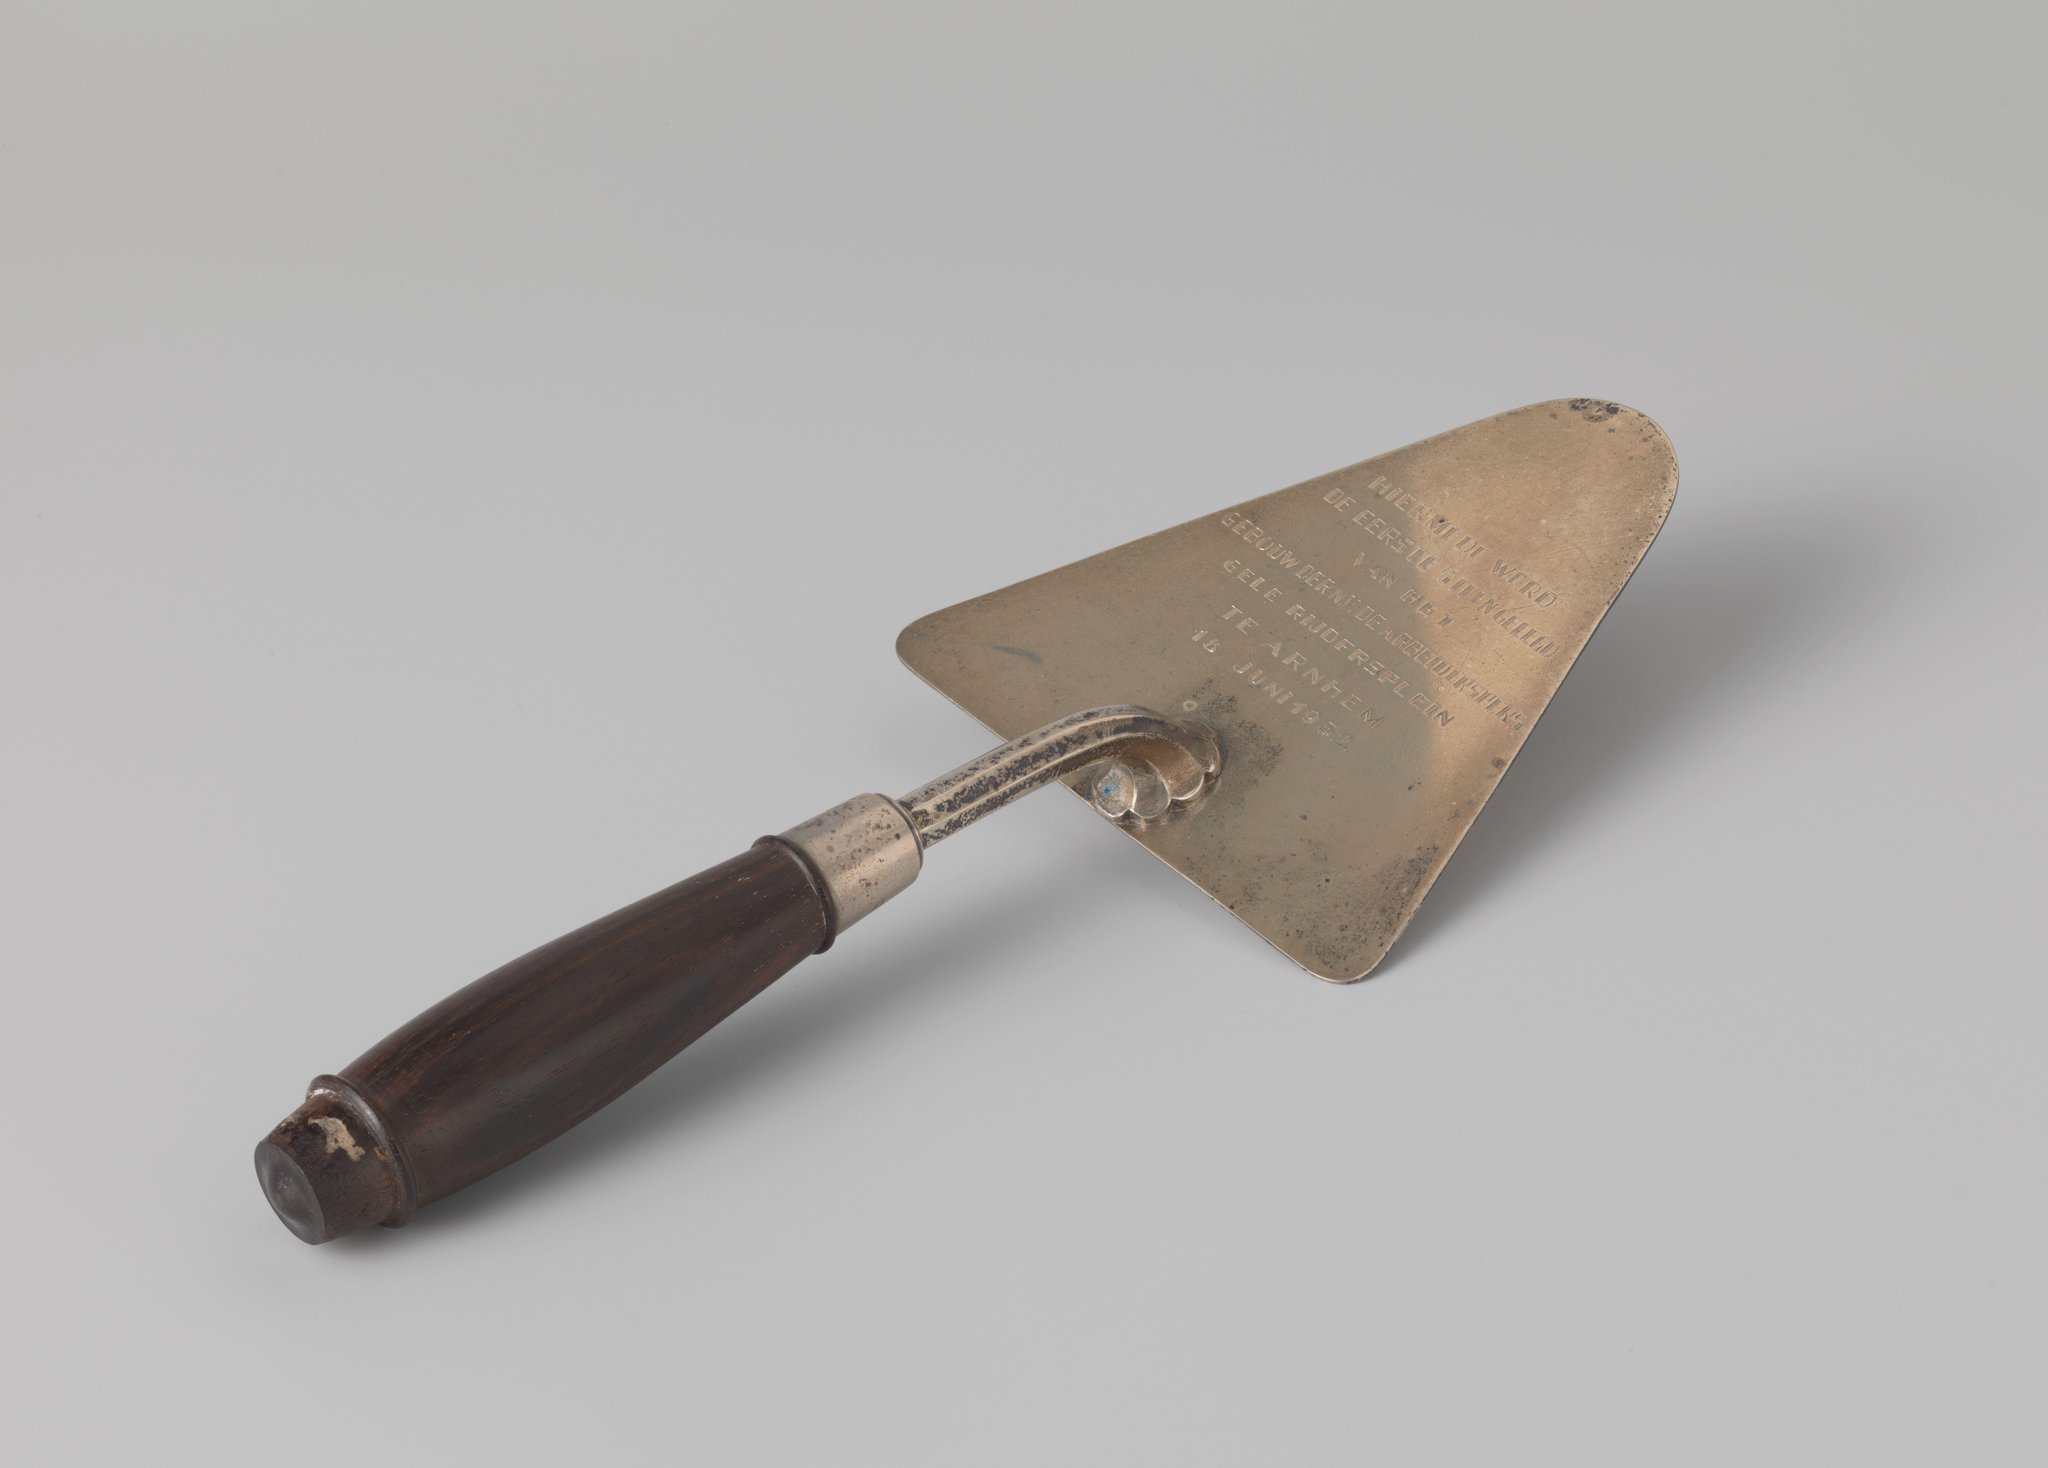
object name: trowel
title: Troffel gebruikt voor eerste steen van het gebouw der N.V. Arbeiderspers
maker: Anonymous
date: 1950-1952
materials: metal, silver, wood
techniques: engraving, turning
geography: utrecht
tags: amsterdam, the hague, willem drees, arnhem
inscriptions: date: ‘1950’, inscription: ‘Hiermede werd de eerste steen gelegd van het gebouw der N.V. De Arbeiderspers Gele Rijdersplein te Arnhem 18 juni 1952’, mark: ‘VK’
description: Driehoekige troffel met afgeronde hoeken. Achthoekige steel waarvan begin en einde breder uitlopen. Halverwege de steel is het handvat, van donkerkleurighout, bevestigd.